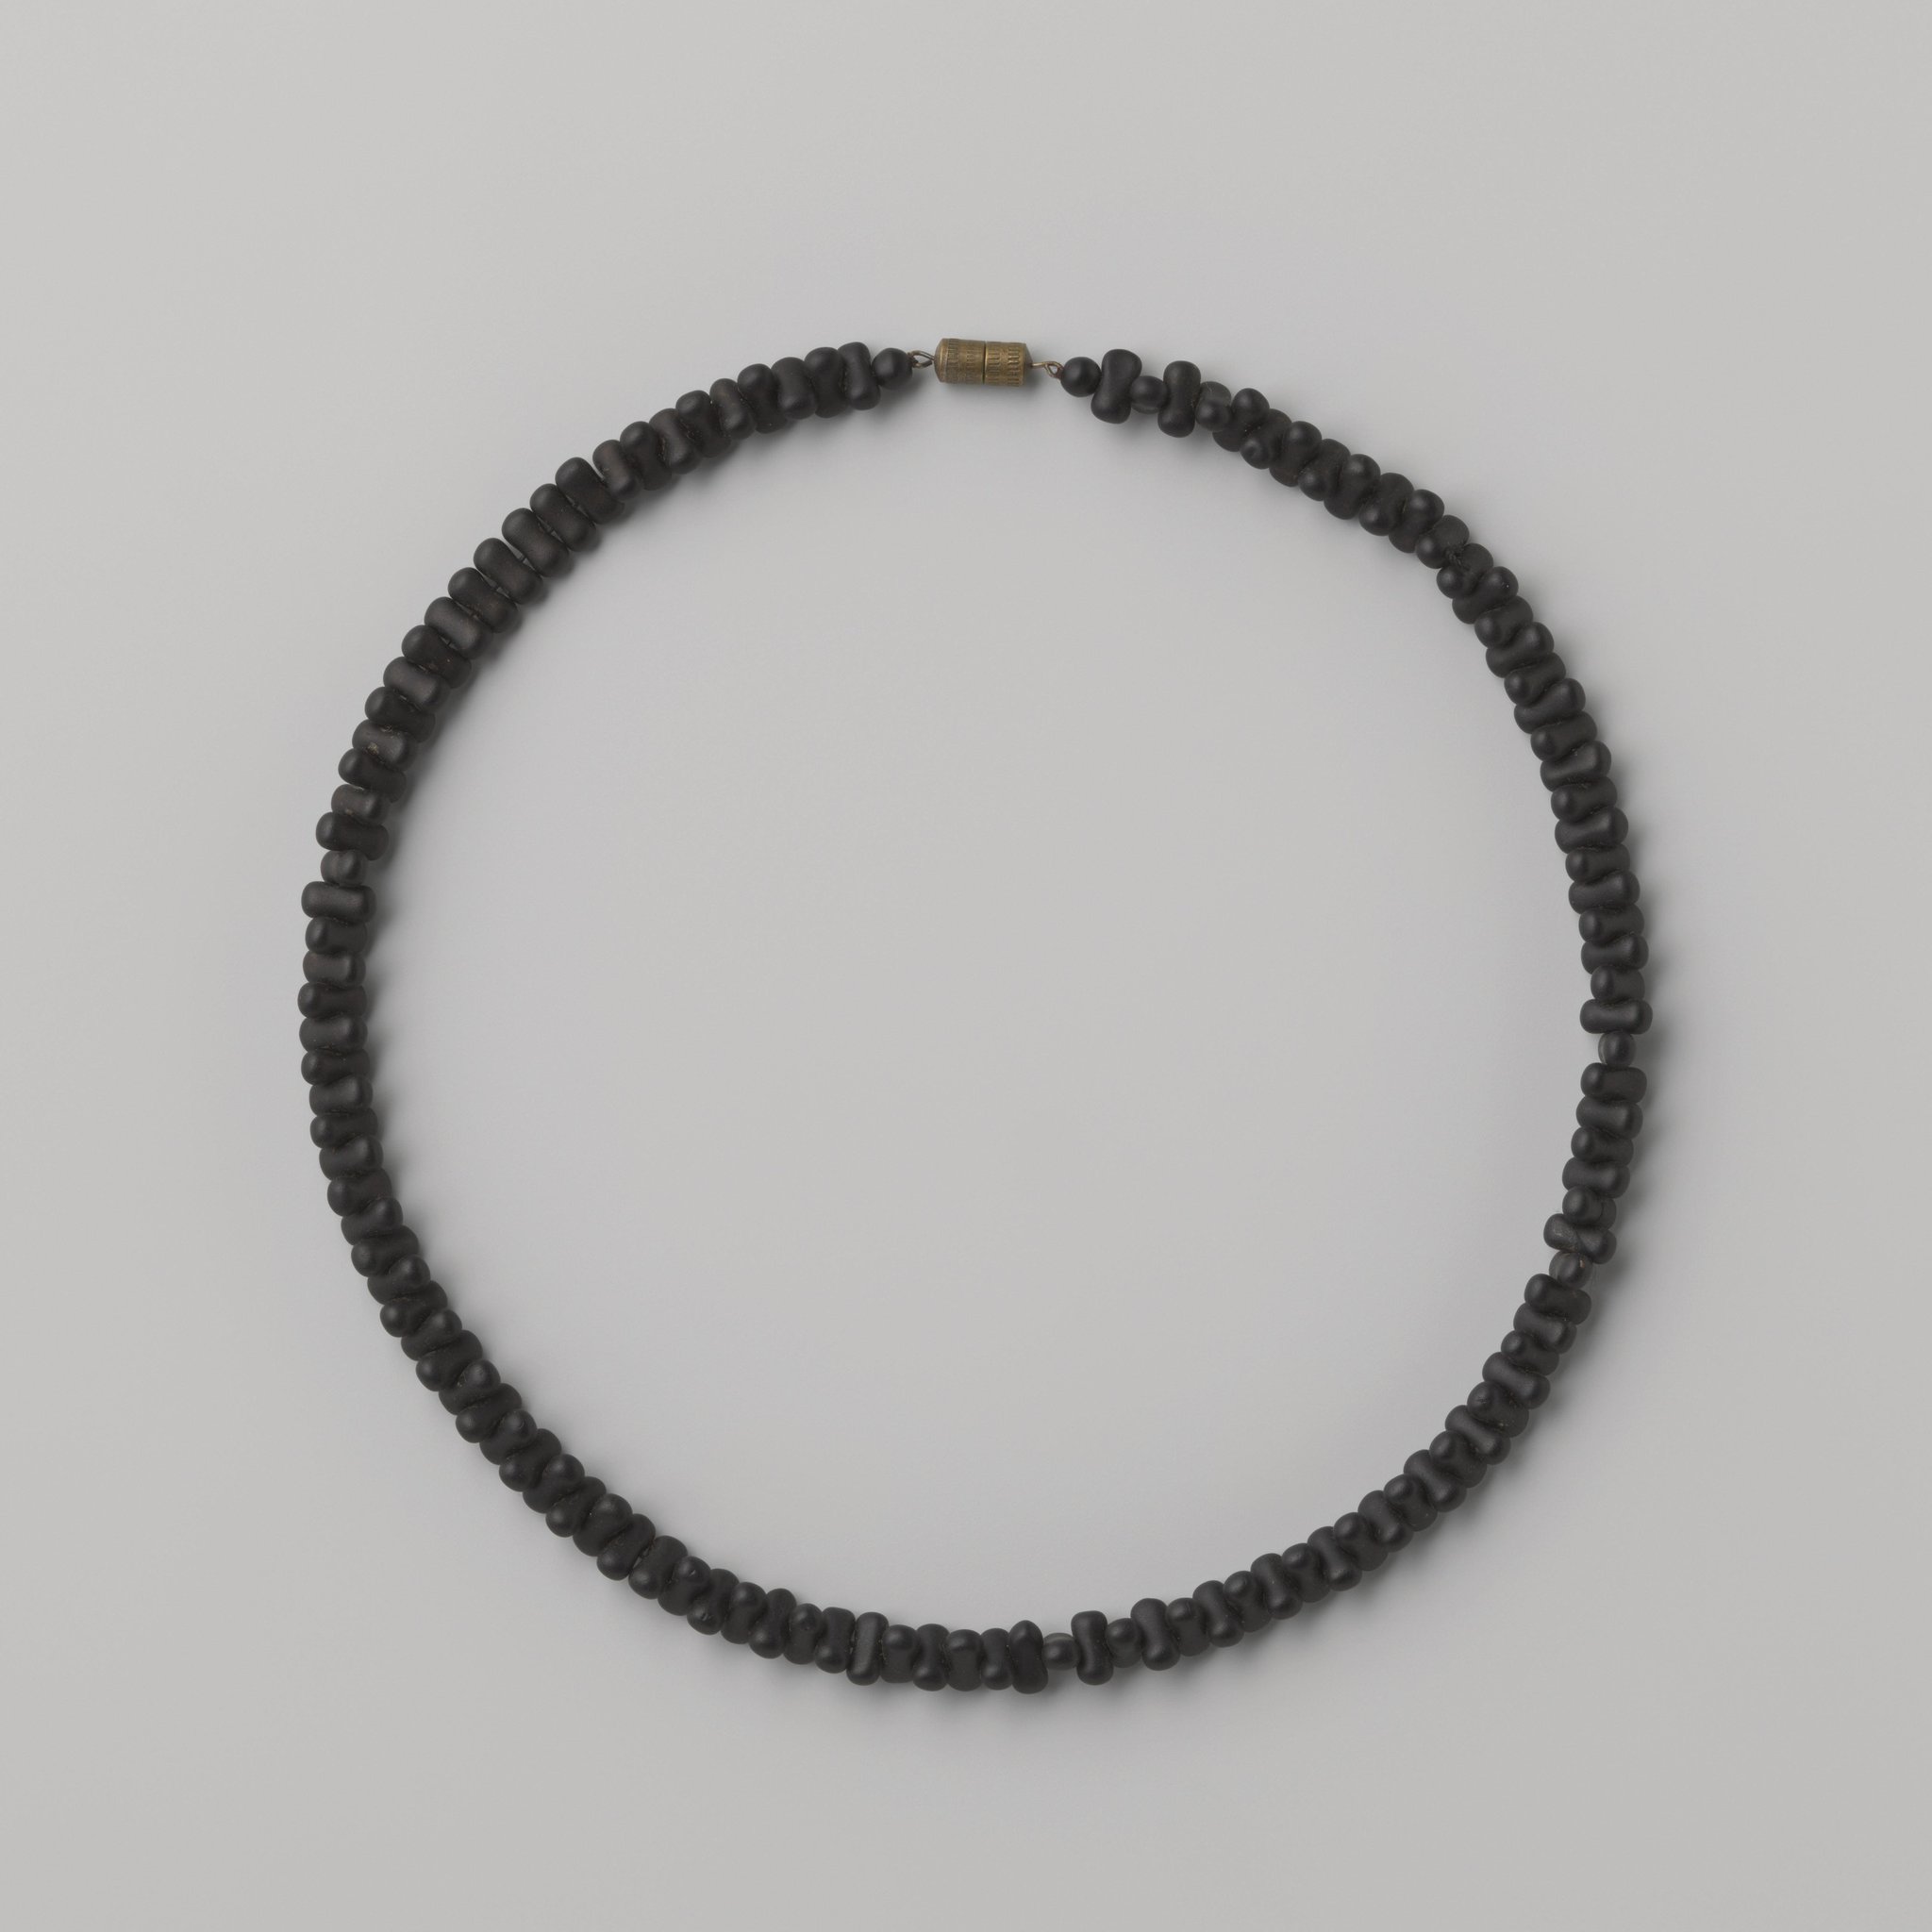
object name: necklace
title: Rouwcollier van zwarte kralen van glas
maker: Anonymous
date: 1880-1900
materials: glass, metal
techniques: sewing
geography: europe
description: Rouwcollier van zwarte kralen van glas. De kralen hebben de vorm van een staaf, iets verdund in het midden, waardoor de kralen zich alternerend schikken aan de zwarte draad waaraan ze geregen zijn. Het collier sluit door middel van twee stukken metaal met schroefdraad.